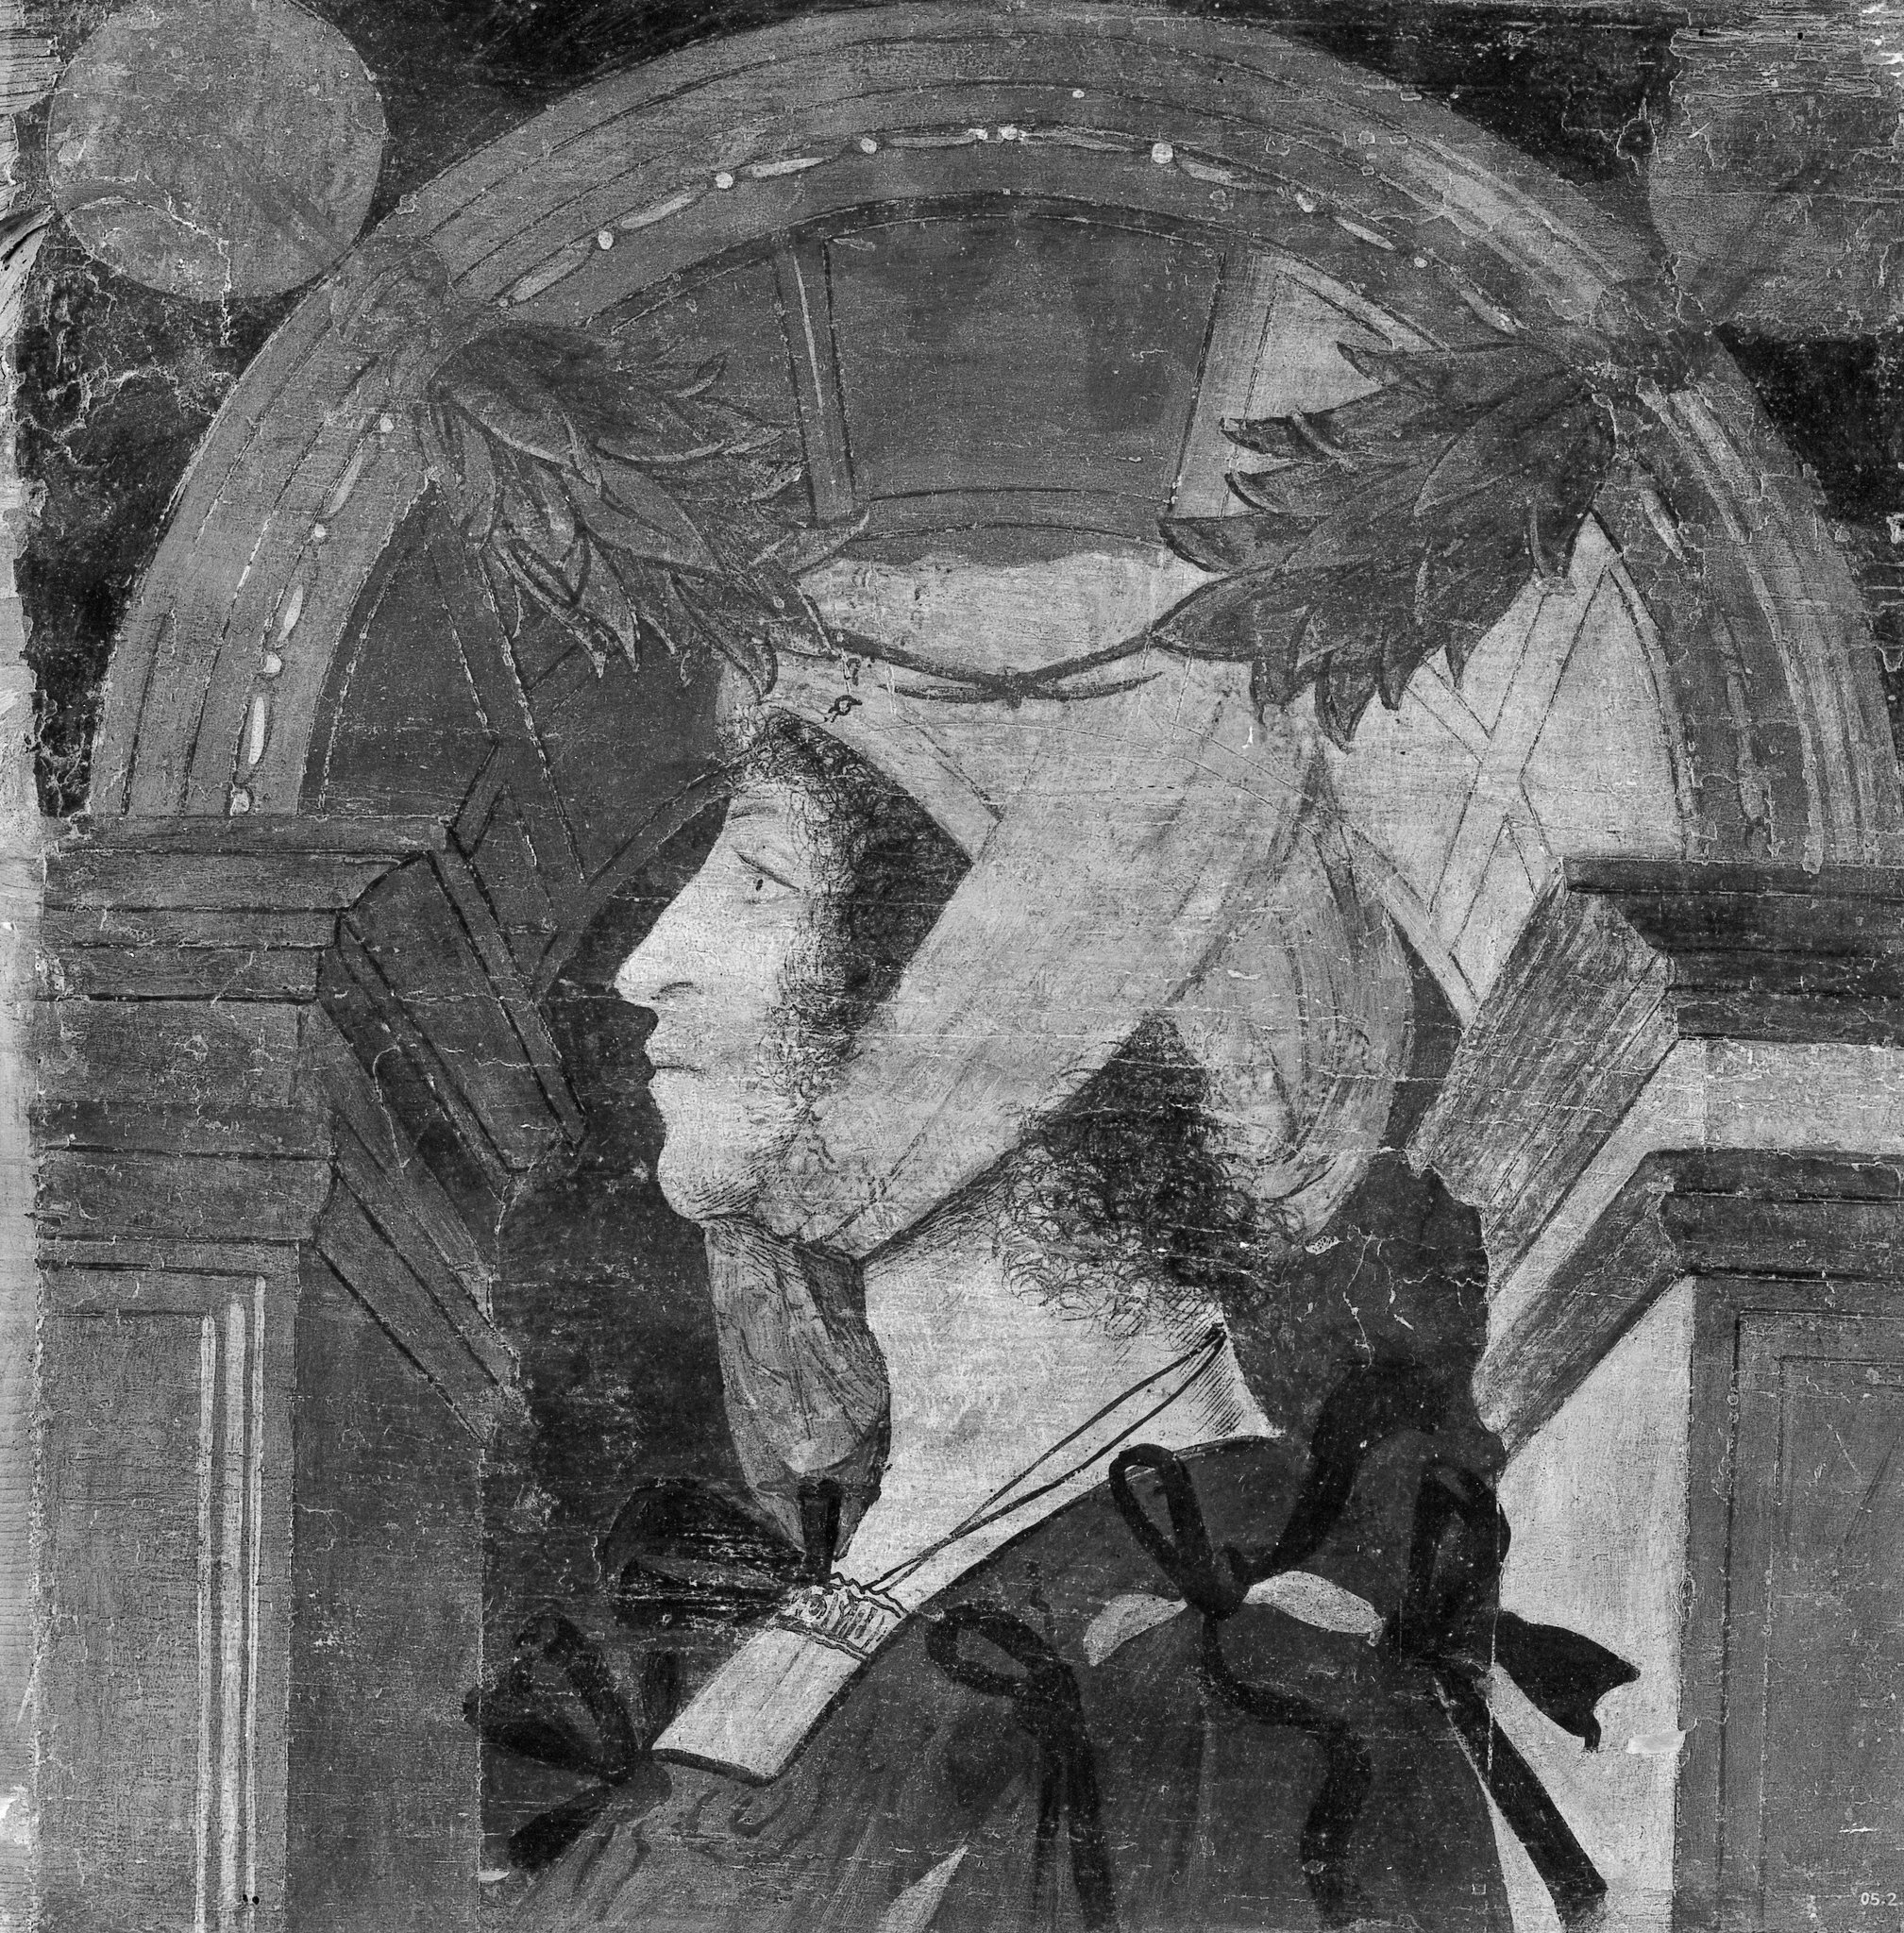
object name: painting, panel of a frieze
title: Twelve Heads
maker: italian (lombard) painter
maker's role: artist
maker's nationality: italian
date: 1500-1524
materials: paint, wood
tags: heads,men,portraits,profiles,women